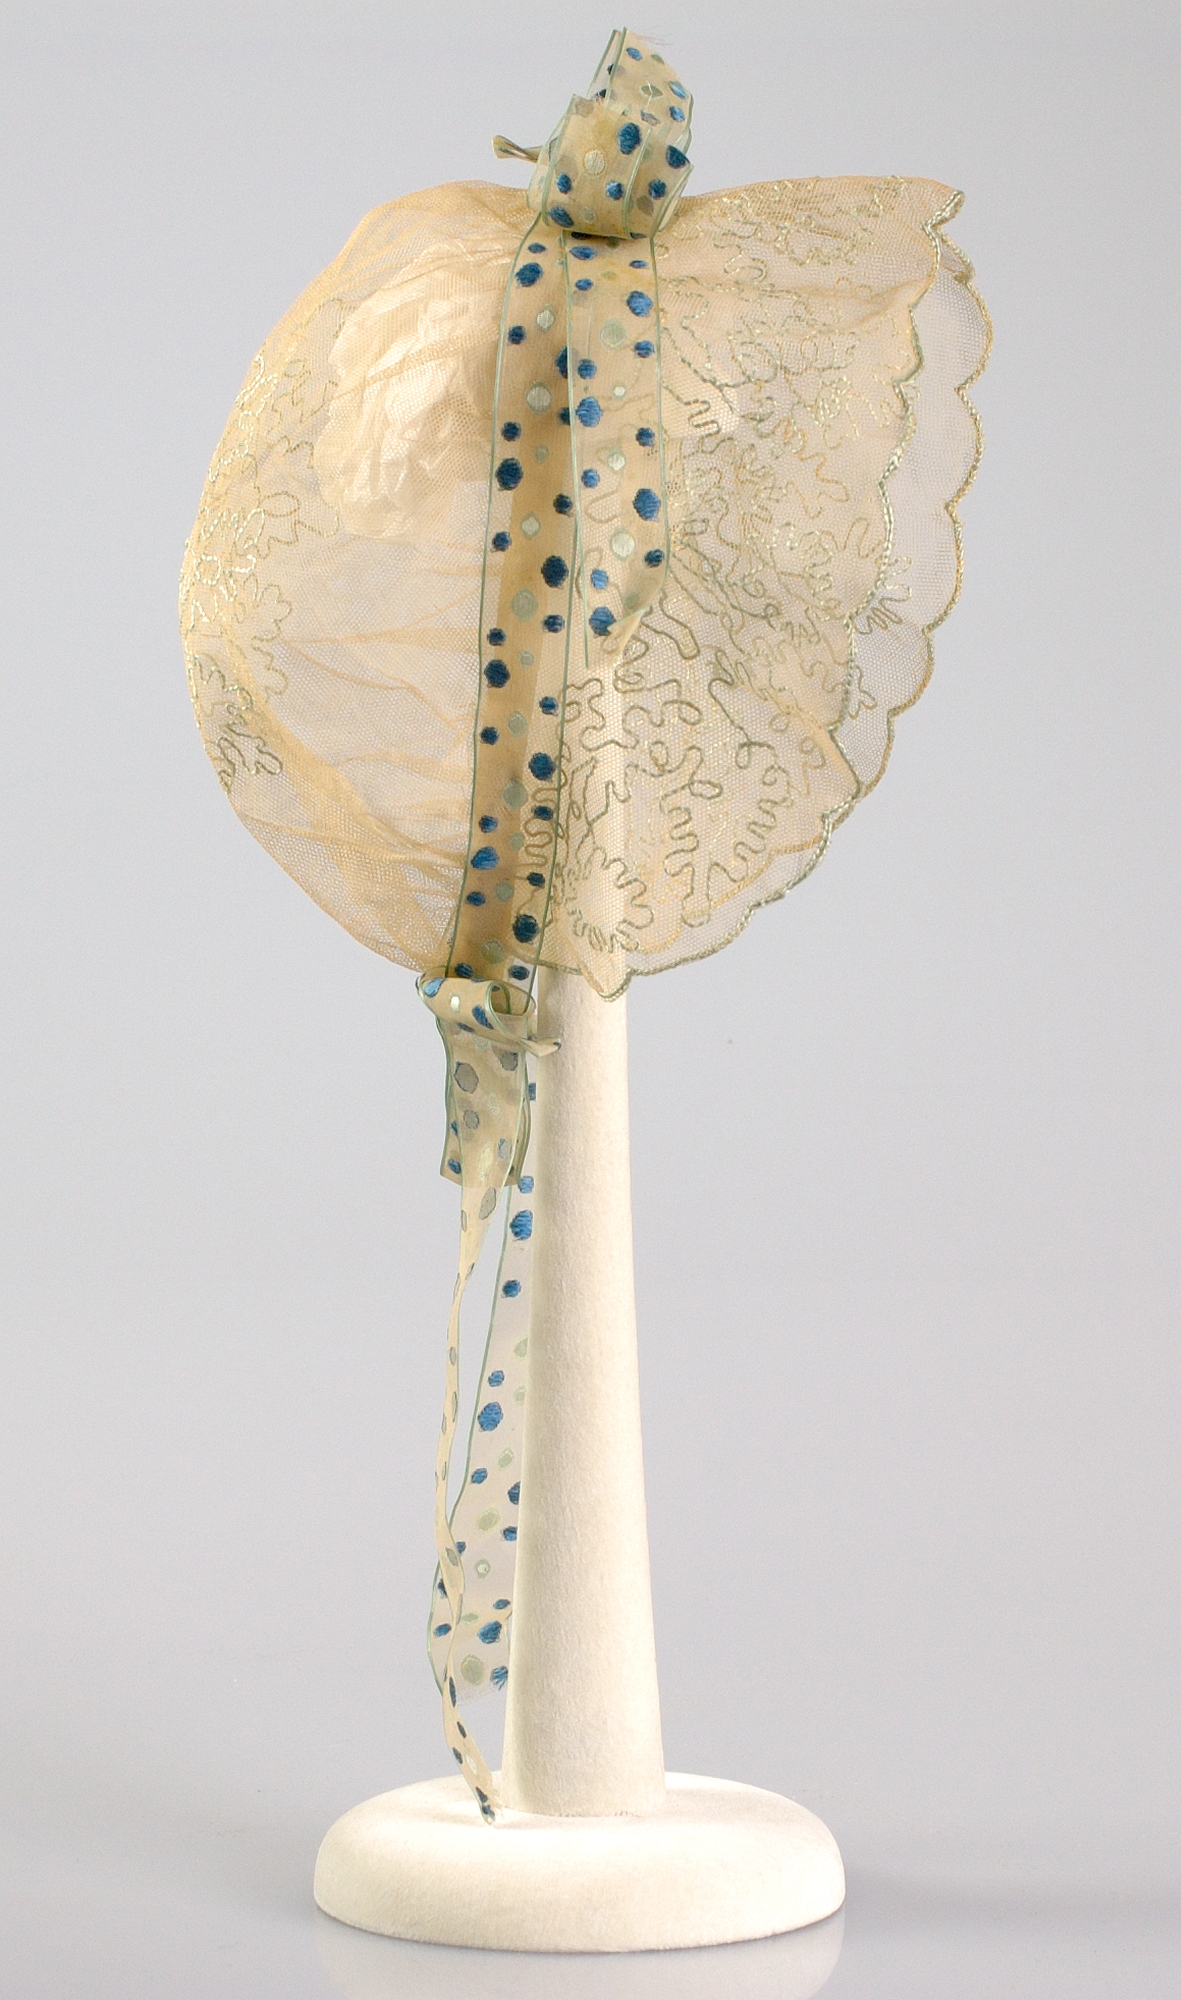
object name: cap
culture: american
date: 1860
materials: silk